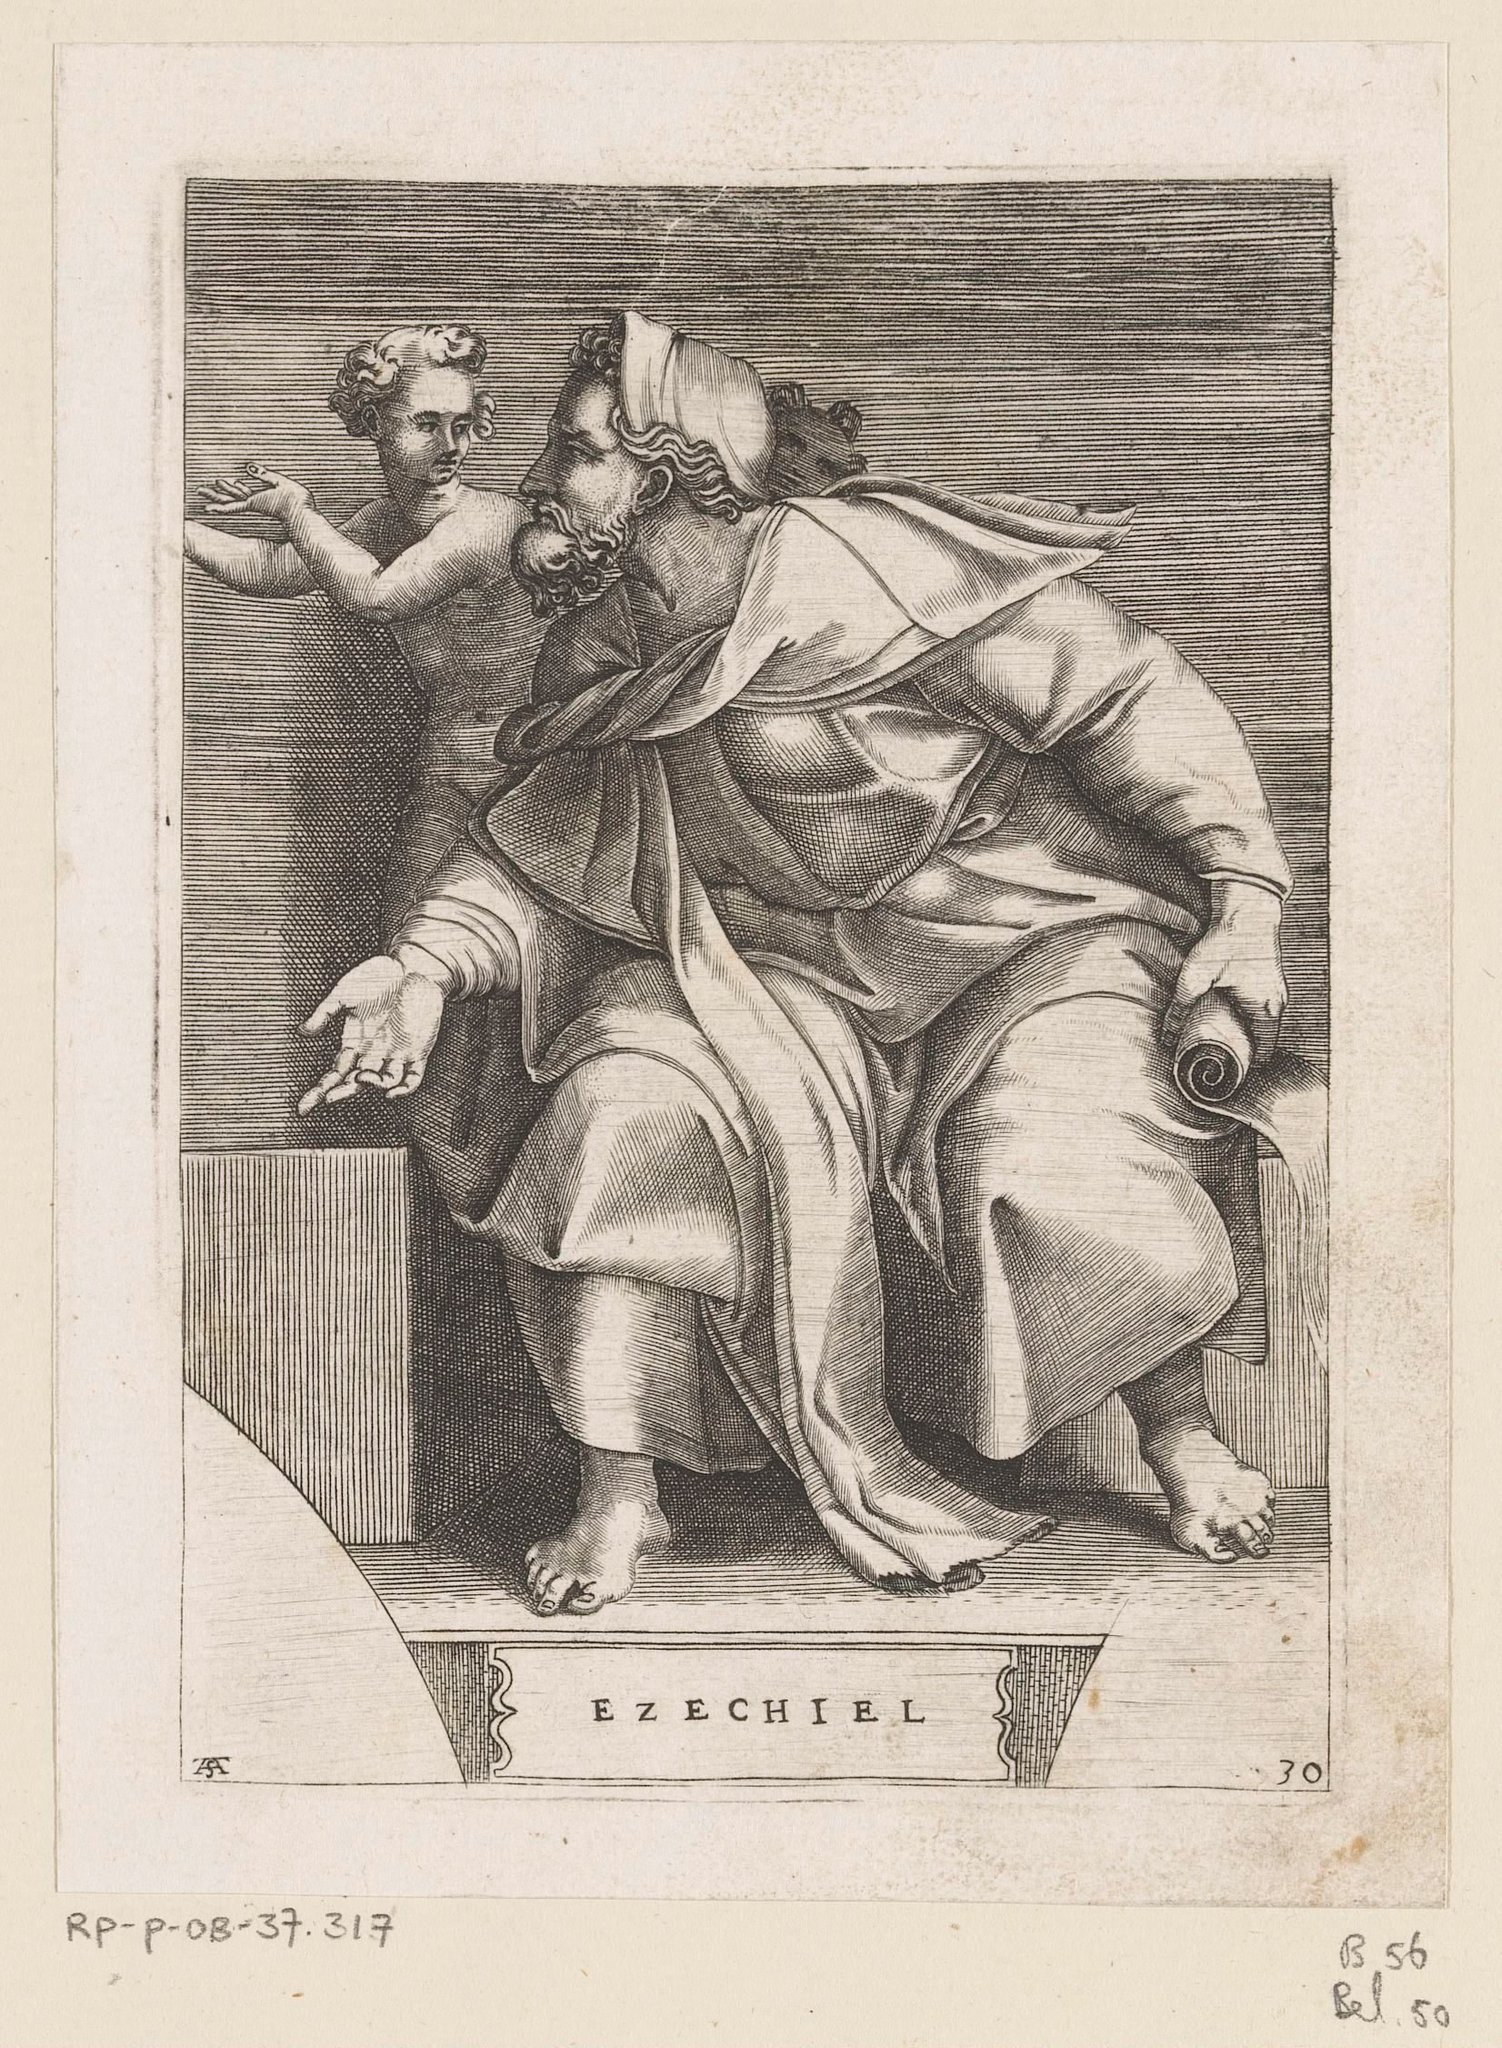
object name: print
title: Profeet Ezechiël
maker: adamo scultori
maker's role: painter, print maker, sculptor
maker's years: 1530-1585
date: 1585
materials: paper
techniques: engraving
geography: italy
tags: ezekiel (not in biblical context); possible attributes: book or scroll, double wheel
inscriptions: collector's mark: Lugt 240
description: De profeet Ezechiël zittend met boekrol en twee naakte figuren. Eén van de profeten van Michelangelo's plafondschildering. Titel in ondermarge en genummerd rechtsonder: 30.